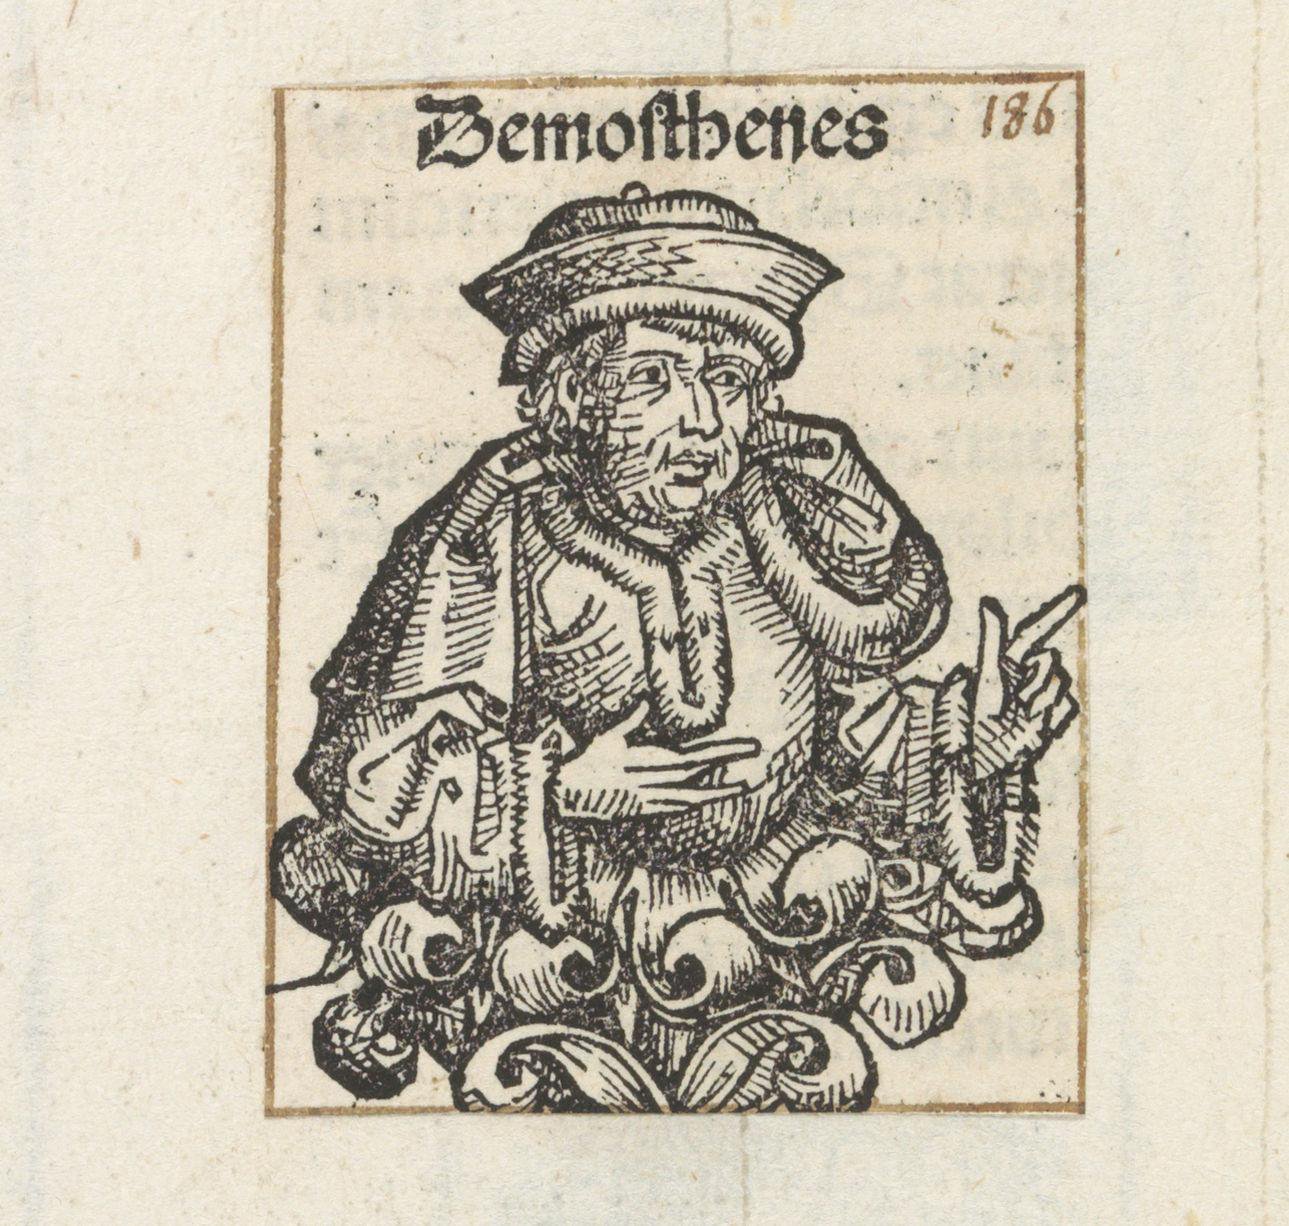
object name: print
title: Liber Chronicarum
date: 1493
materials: paper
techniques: letterpress printing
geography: nuremberg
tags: politician, male persons from classical history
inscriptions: inscription: ‘186’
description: De houtsnede wordt gebruikt als boekillustratie in de Liber Chronicarum (of Neurenbergkroniek) van Hartmann Schedel, verschenen in het Latijn en Duits in 1493. Zie de Latijnse uitgave, folio 78r.